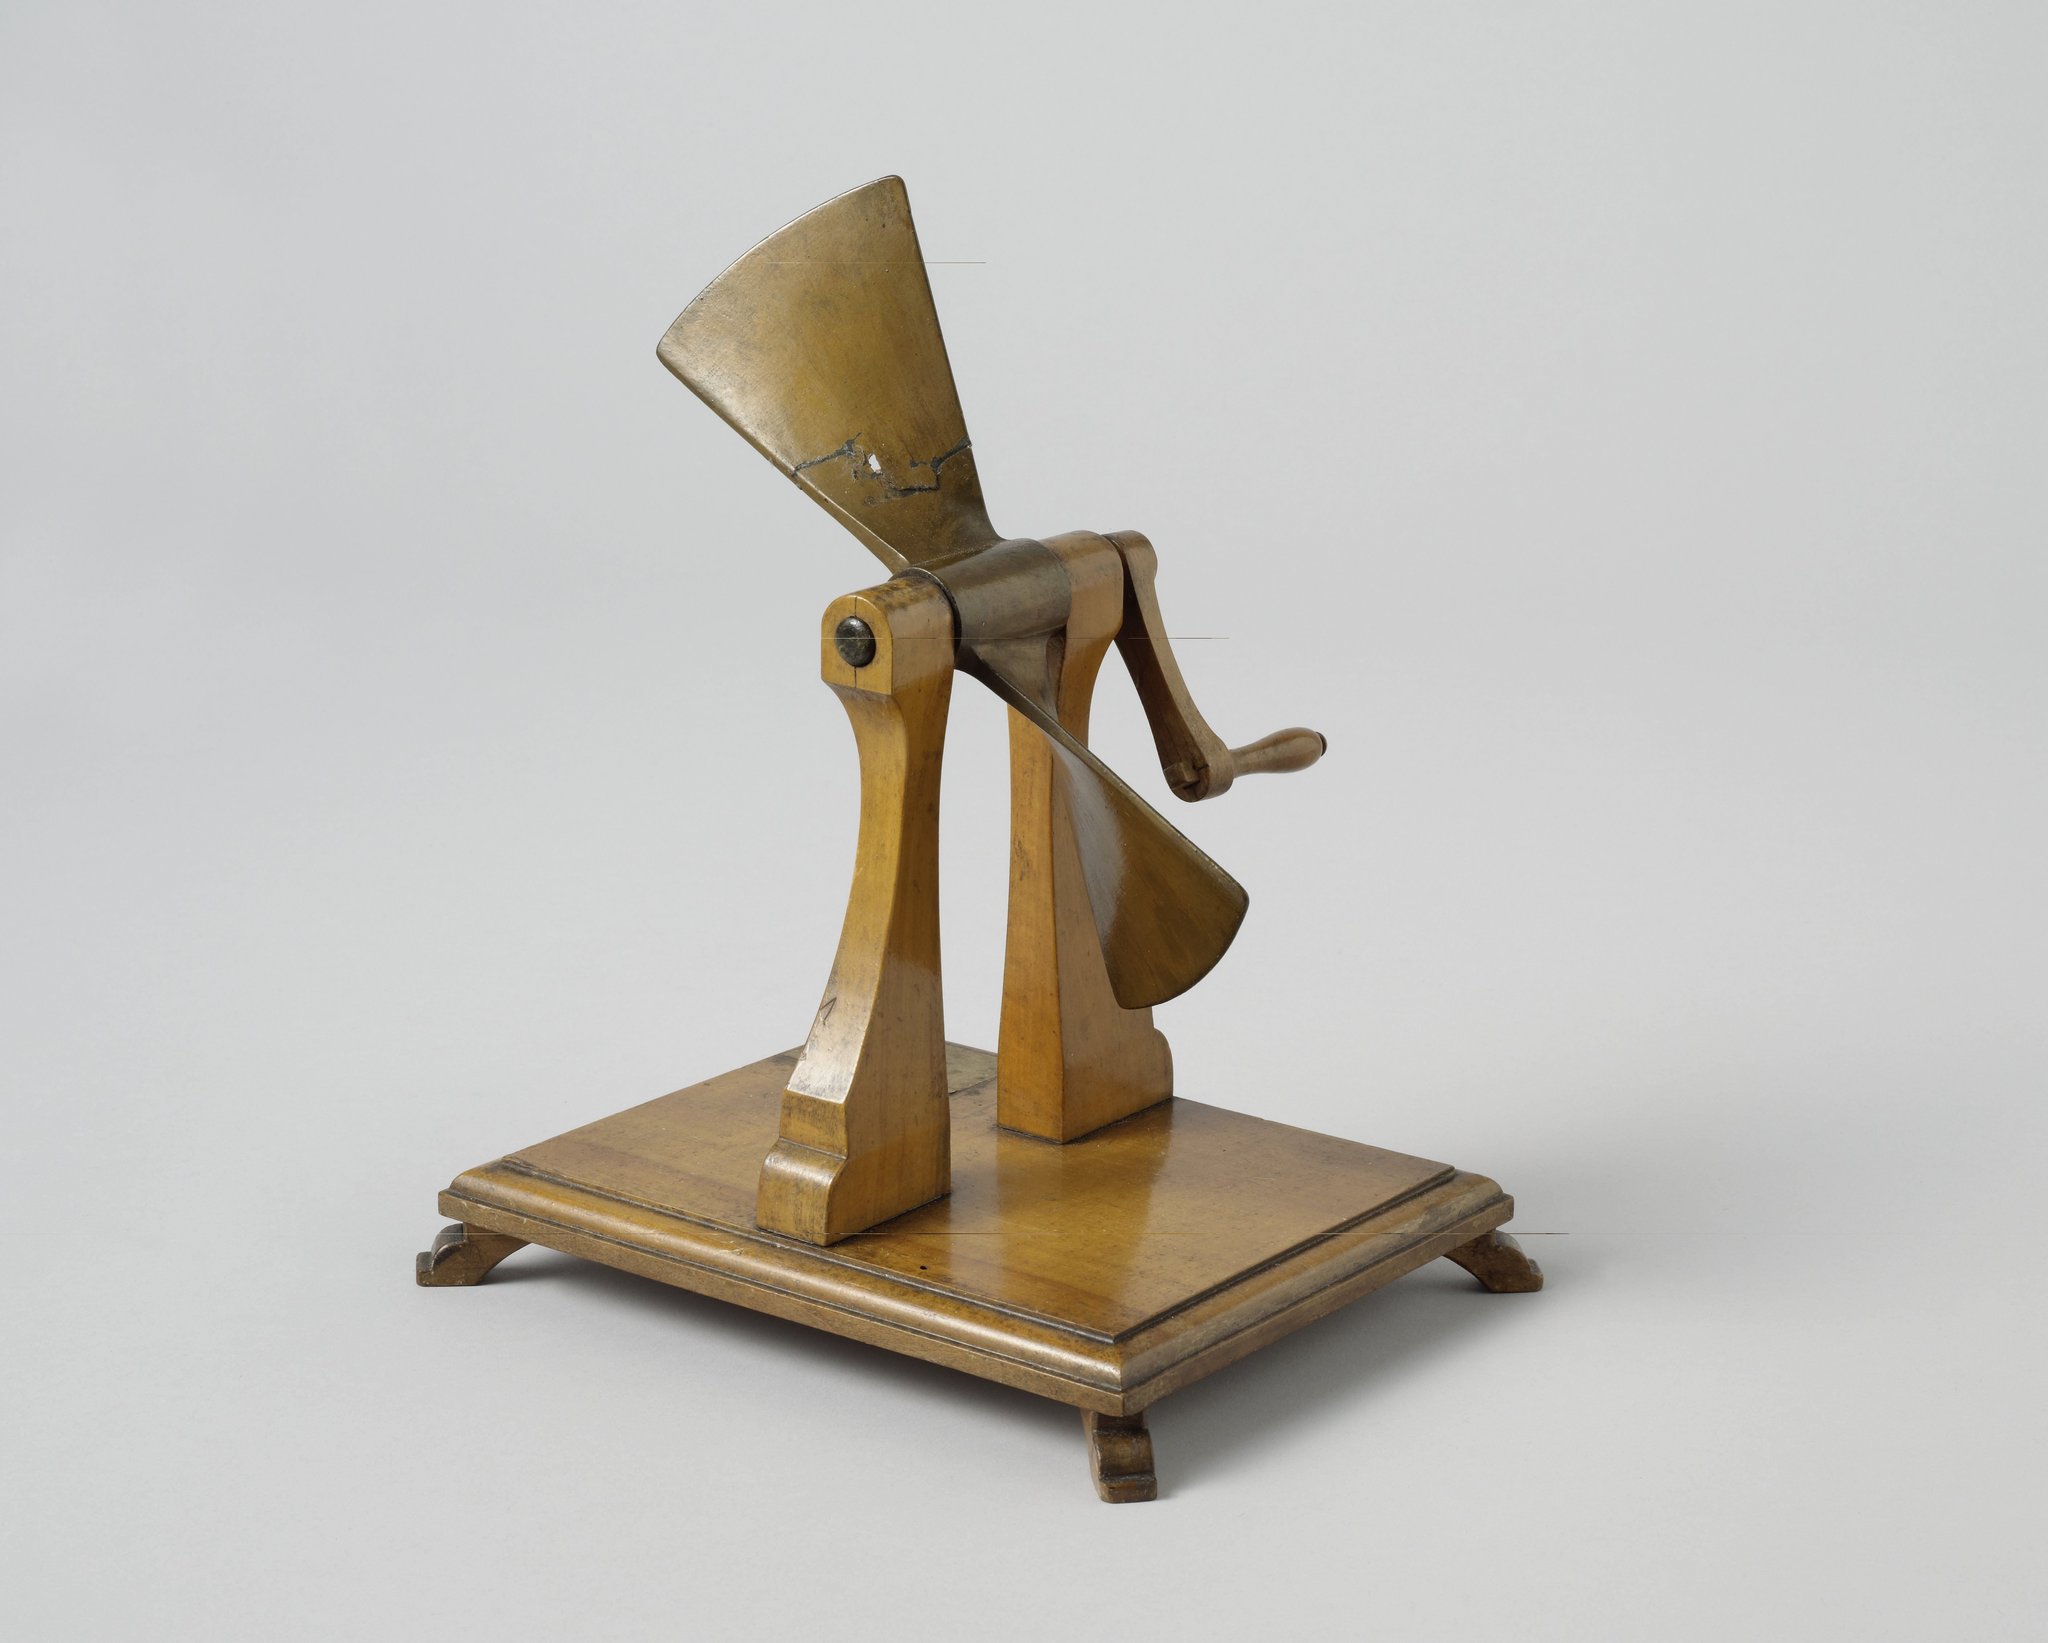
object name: instruction model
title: Model of a two-bladed screw propeller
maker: petrus van der loo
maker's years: 1806-1864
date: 1847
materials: wood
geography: the hague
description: Model van een gewone tweebladige schroef in een frame op een grondplank; tweebladige versie van NG-MC-557. De bladen zijn plat. De schroef kan worden rondgedraaid met een zwengeltje. Het model heeft een spoed van 210 mm, een diameter van 195 mm, de naaf is 40 mm lang en heeft een diameter van 23 mm. Schaal 1:10 (afgeleid).